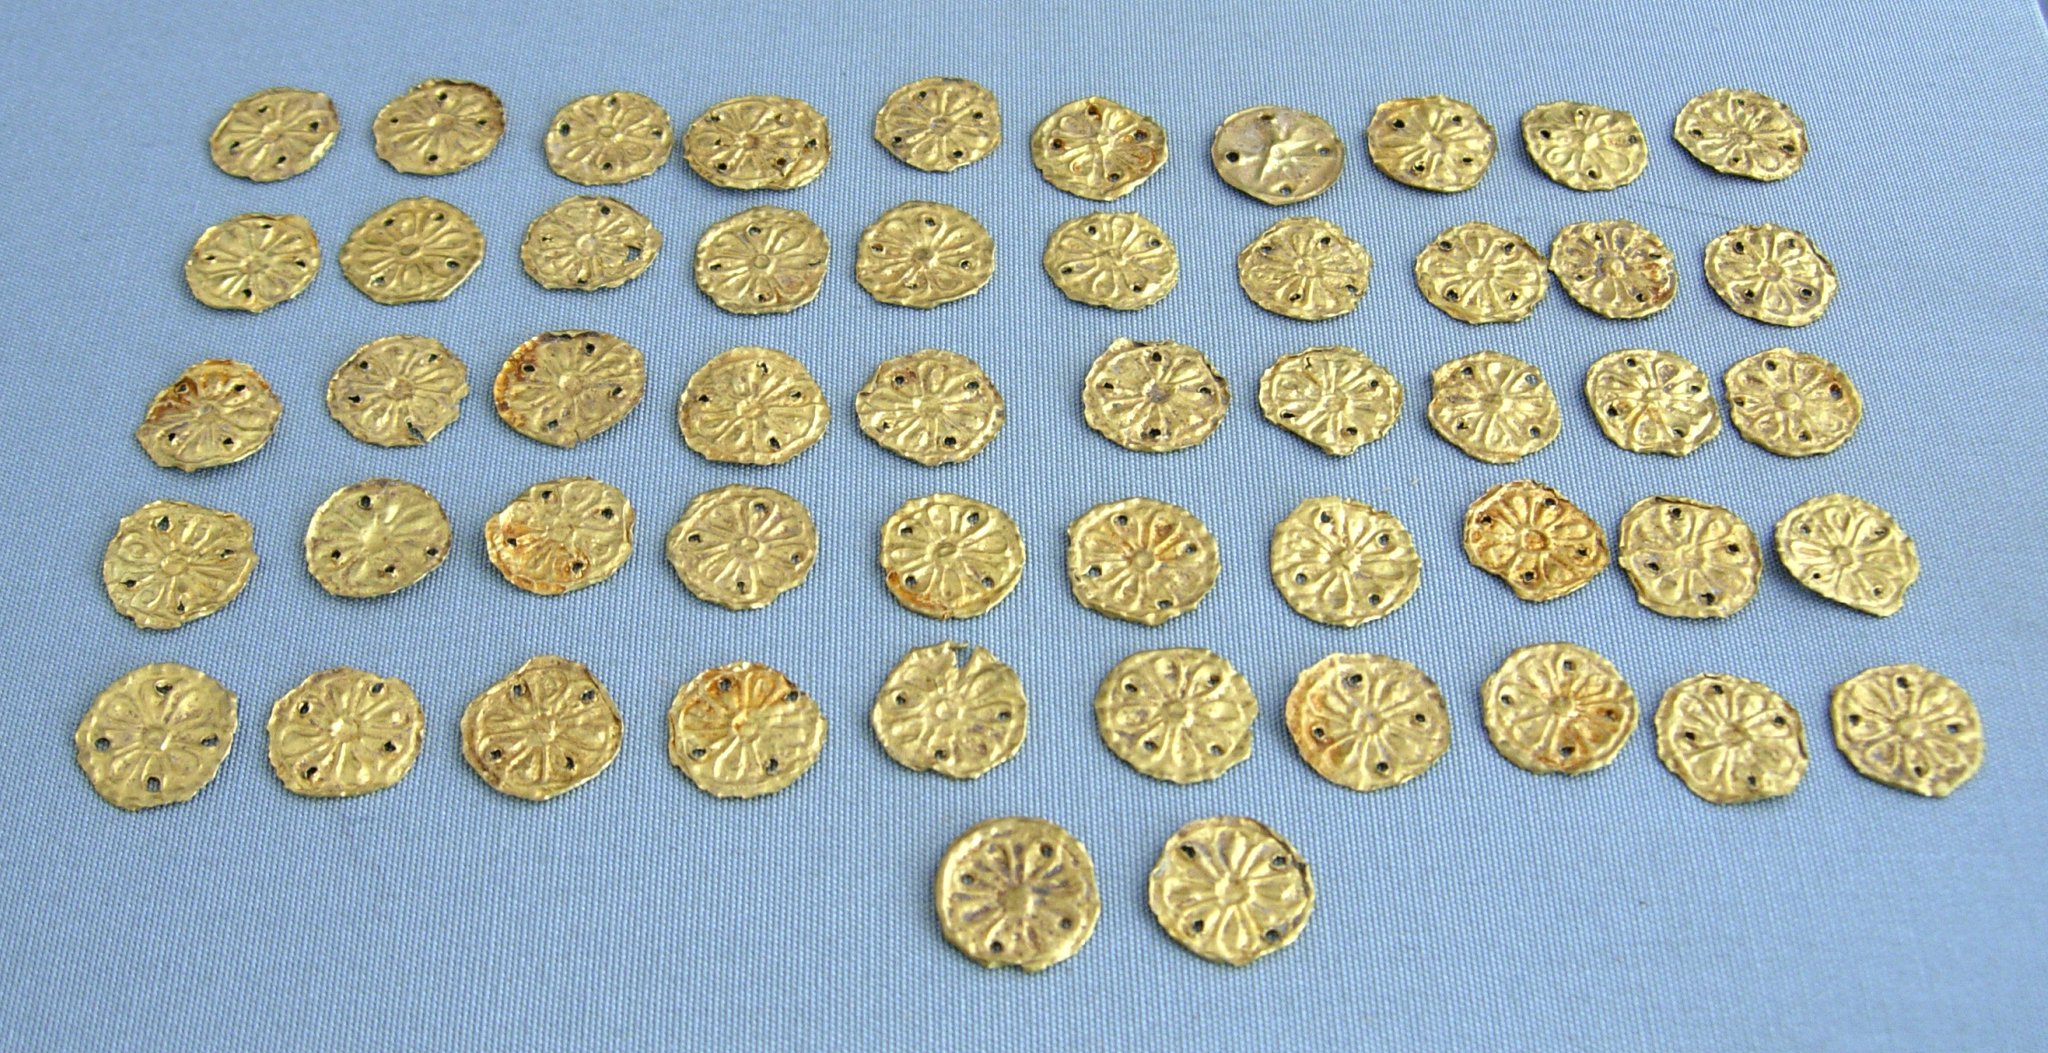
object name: rosette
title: Gold rosette attachments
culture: greek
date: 500-401 BCE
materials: gold